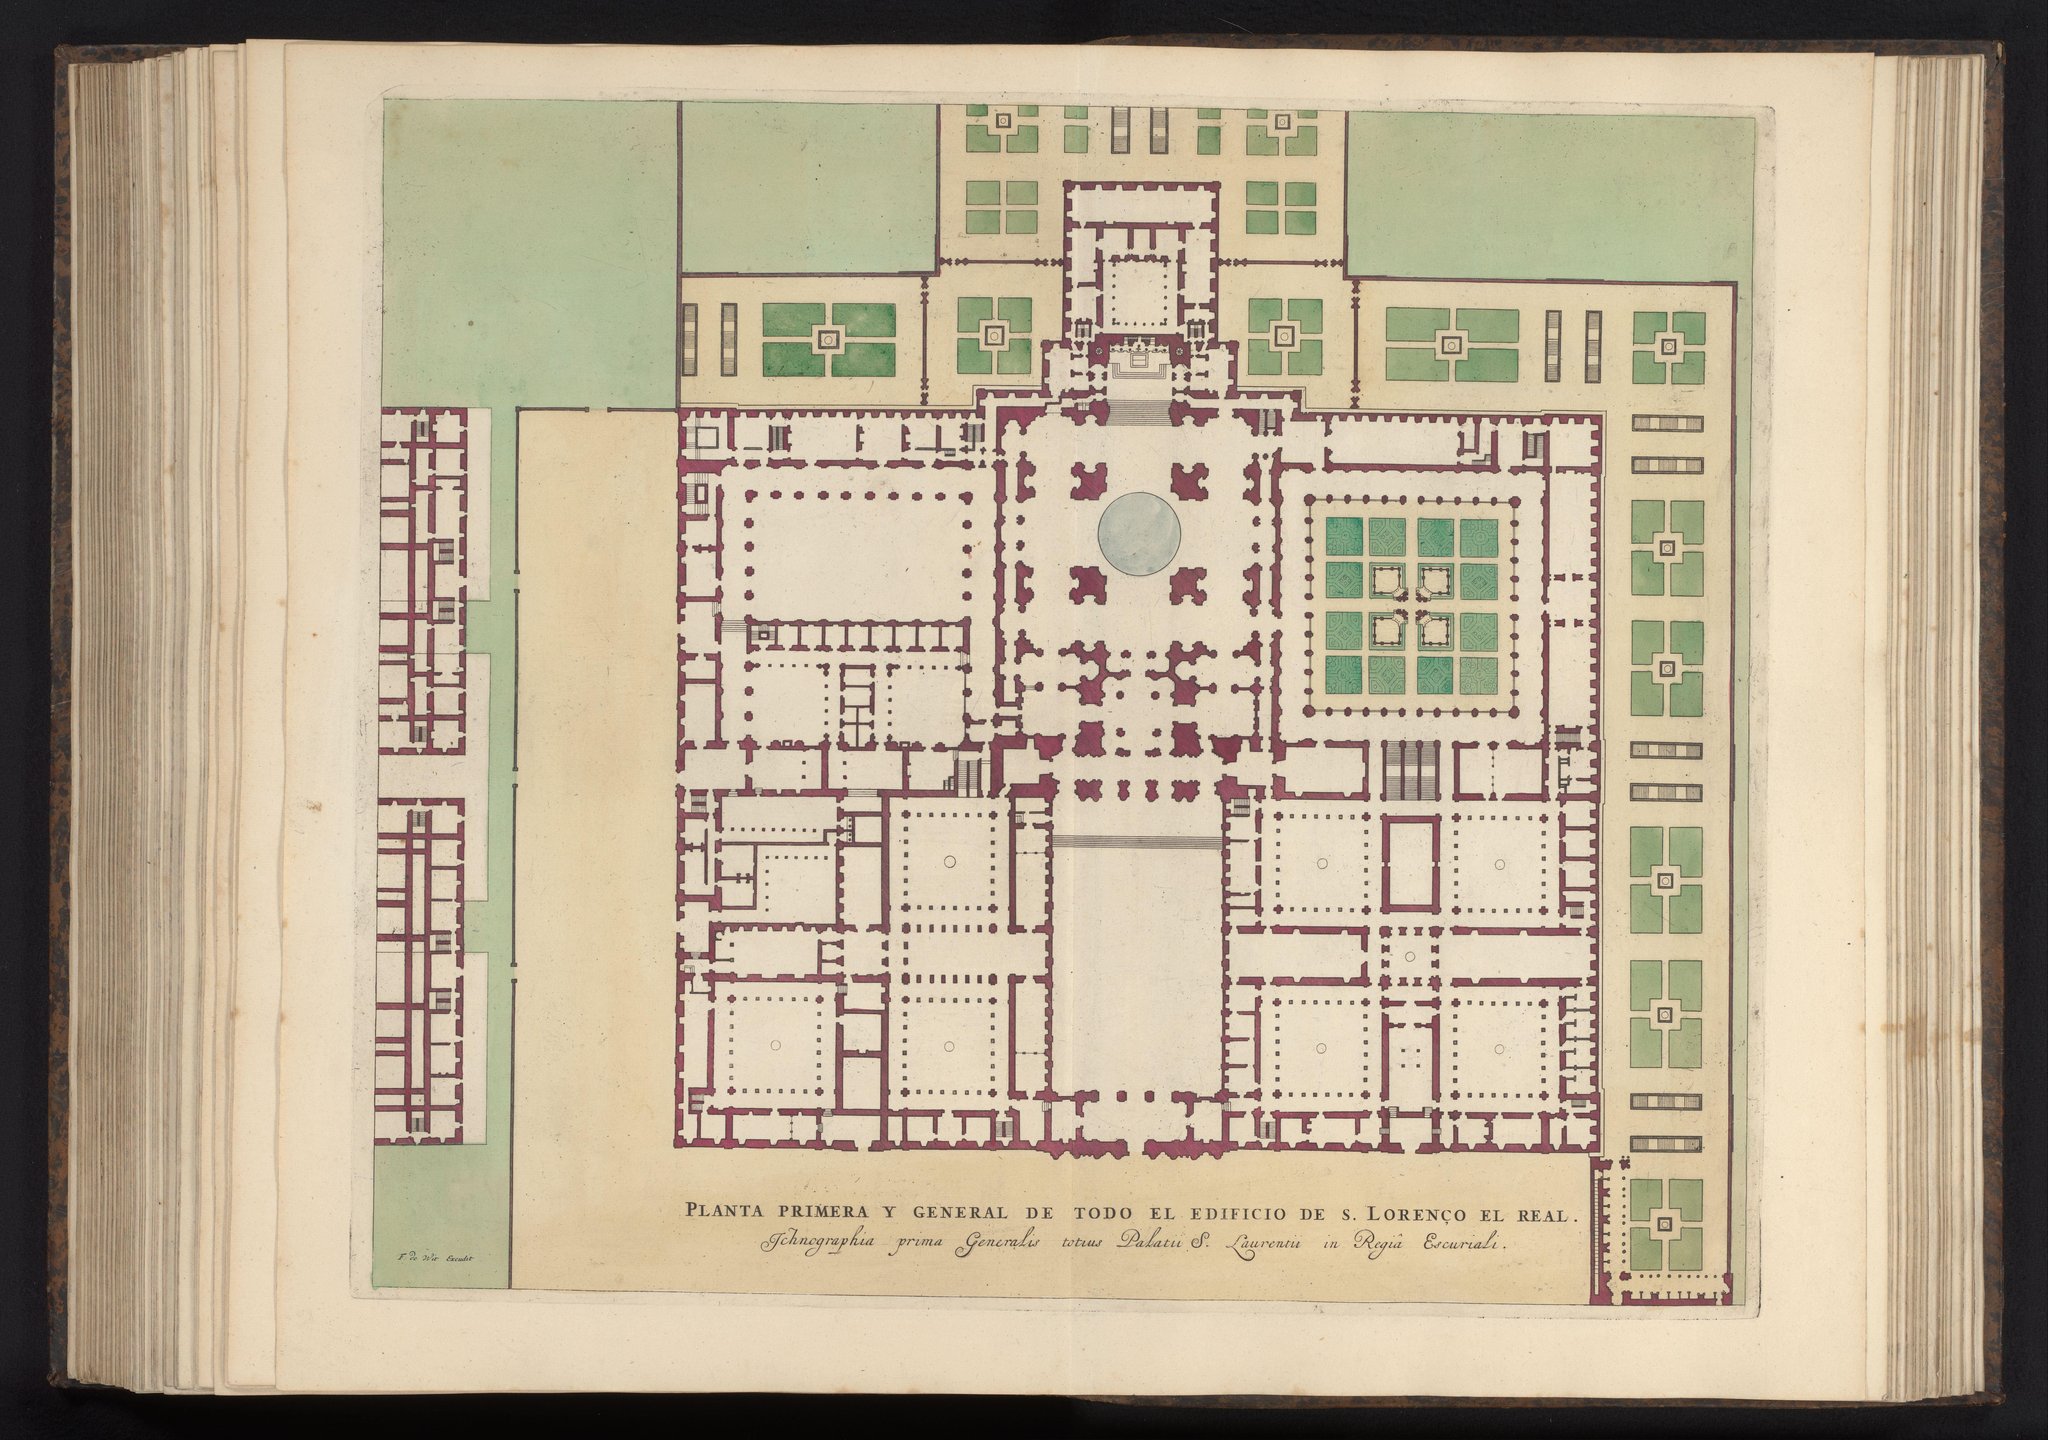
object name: album leaf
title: Plattegrond van het Escorial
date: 1665-1706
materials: paper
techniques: engraving, hand coloring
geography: amsterdam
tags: plan ~ architecture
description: Eerste staat gebruikt in: J. Blaeus Grooten Atlas, oft Werelt- Beschryving, in welcke 't Aerdryck, de Zee, en Hemel, wort vertoont en beschreven. Deel 8 getiteld: Achste stvck der Aerdrycks-Beschryving welck vervat Spaenjen, Africa en America, Amsterdam: Johannes Willemszoon Blaeu, 1665.